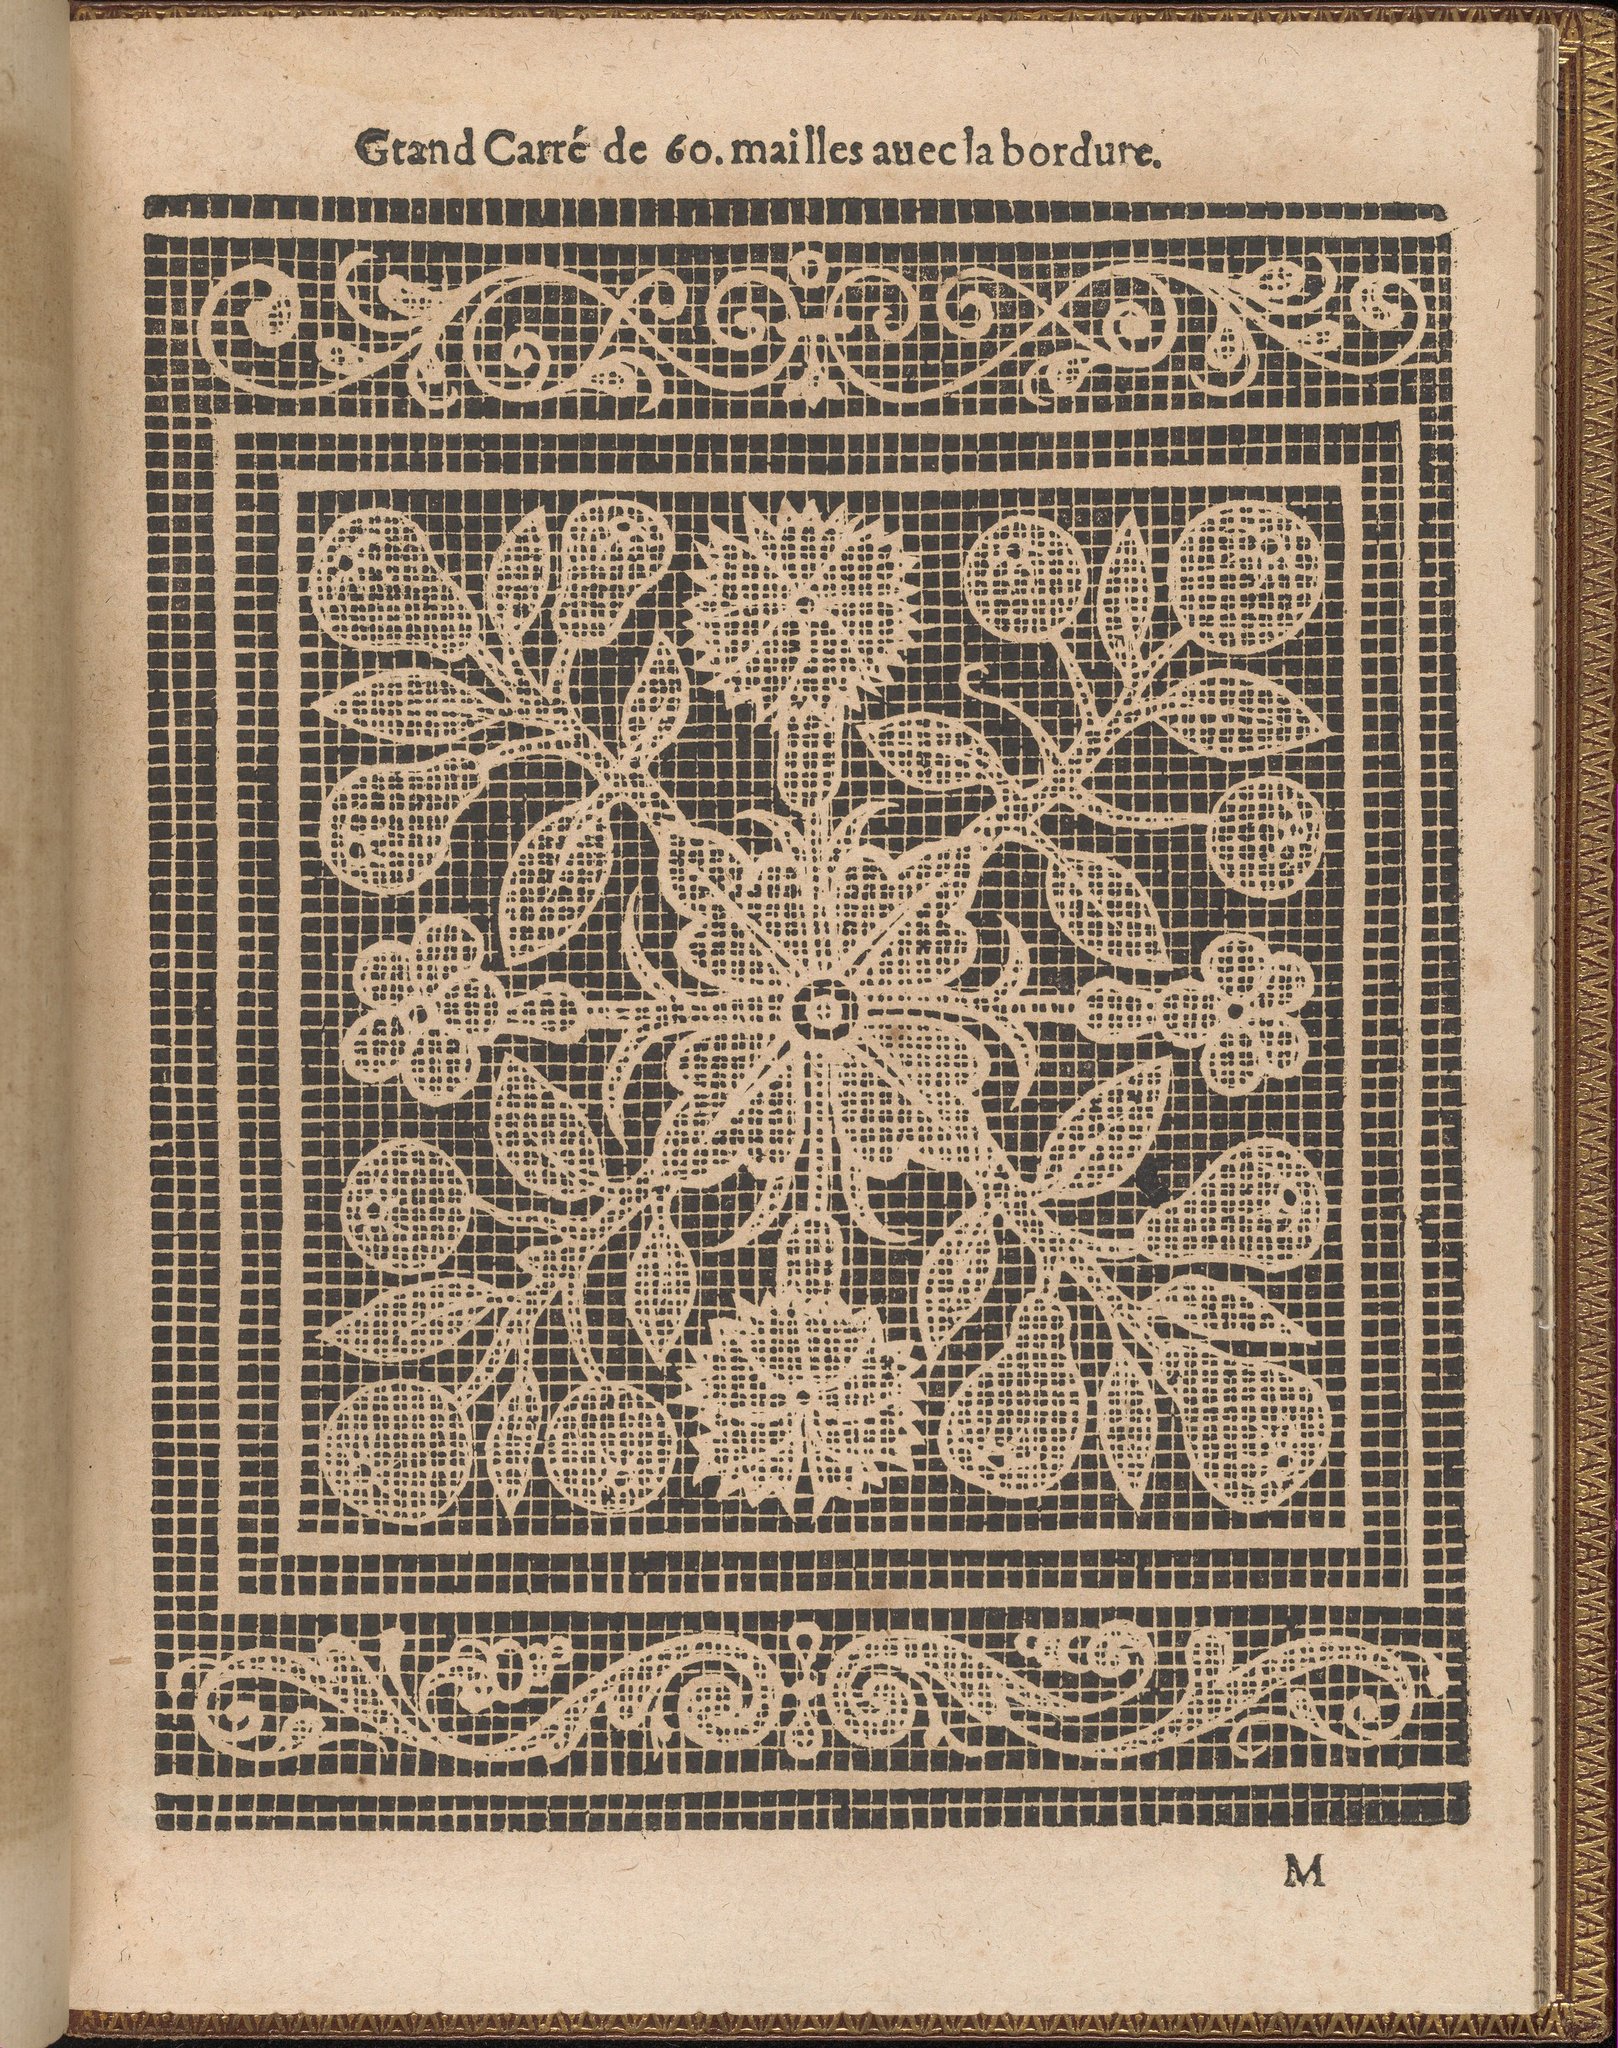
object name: book print ornament architecture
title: La Pratique de l'Aiguille, page 44 (recto)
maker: matthias mignerak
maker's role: author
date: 1605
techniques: woodcut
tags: ornament,fruit